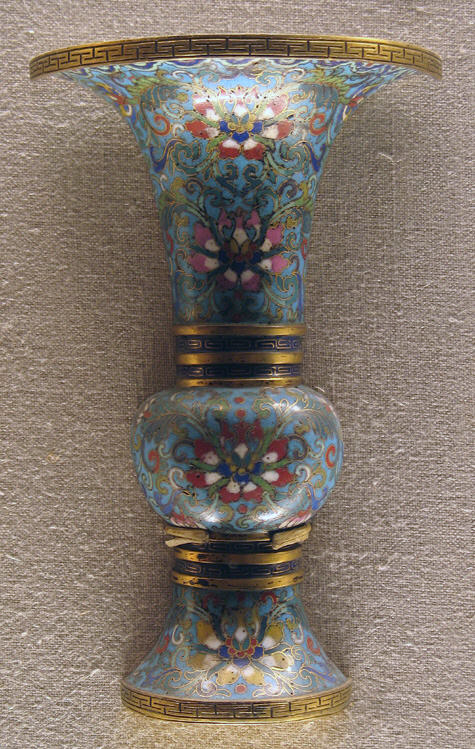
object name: wall vase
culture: chinese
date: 1701-1800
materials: enamel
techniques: enamel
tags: flowers